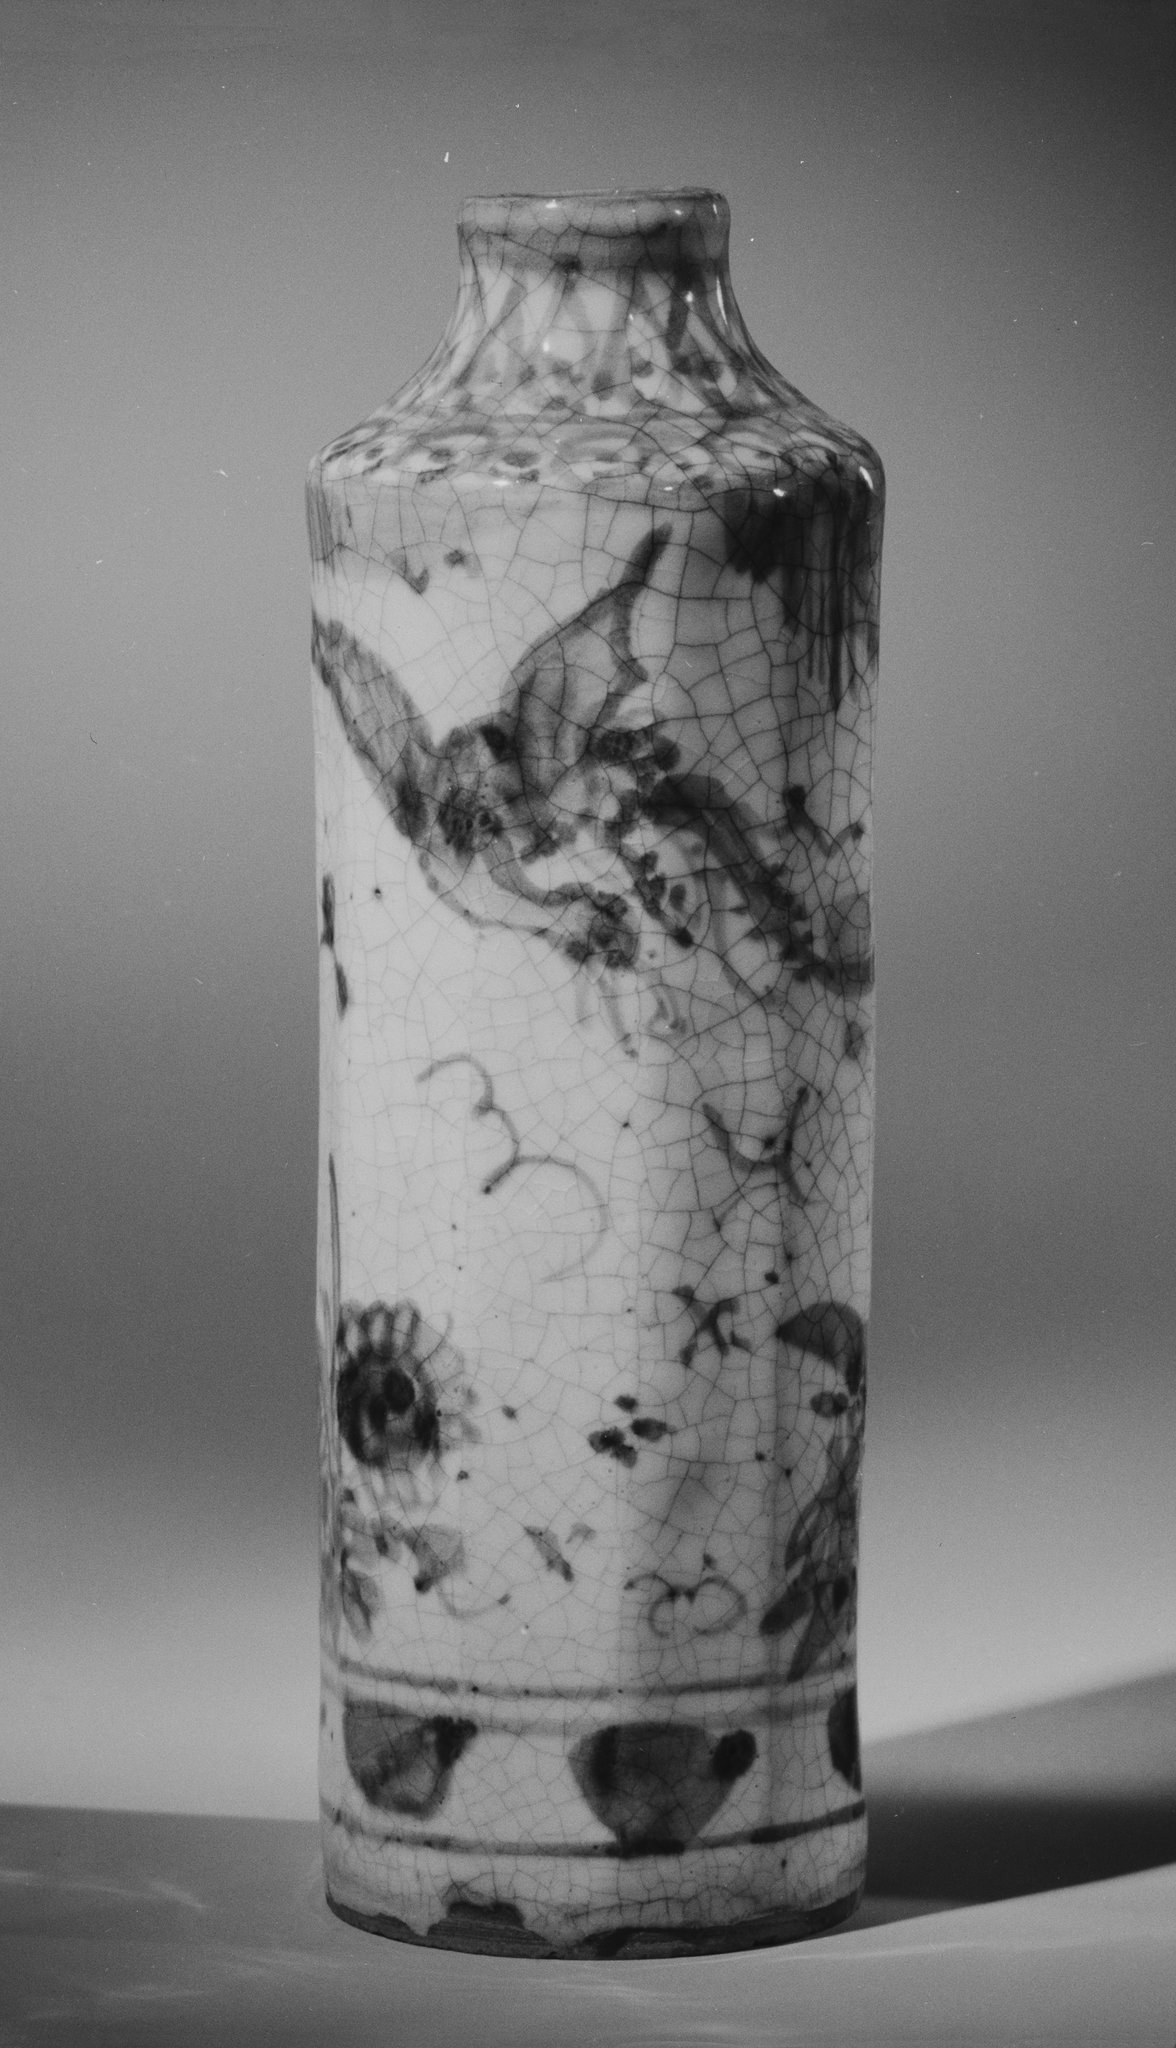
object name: bottle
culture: japanese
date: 1701-1800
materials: glaze, pottery